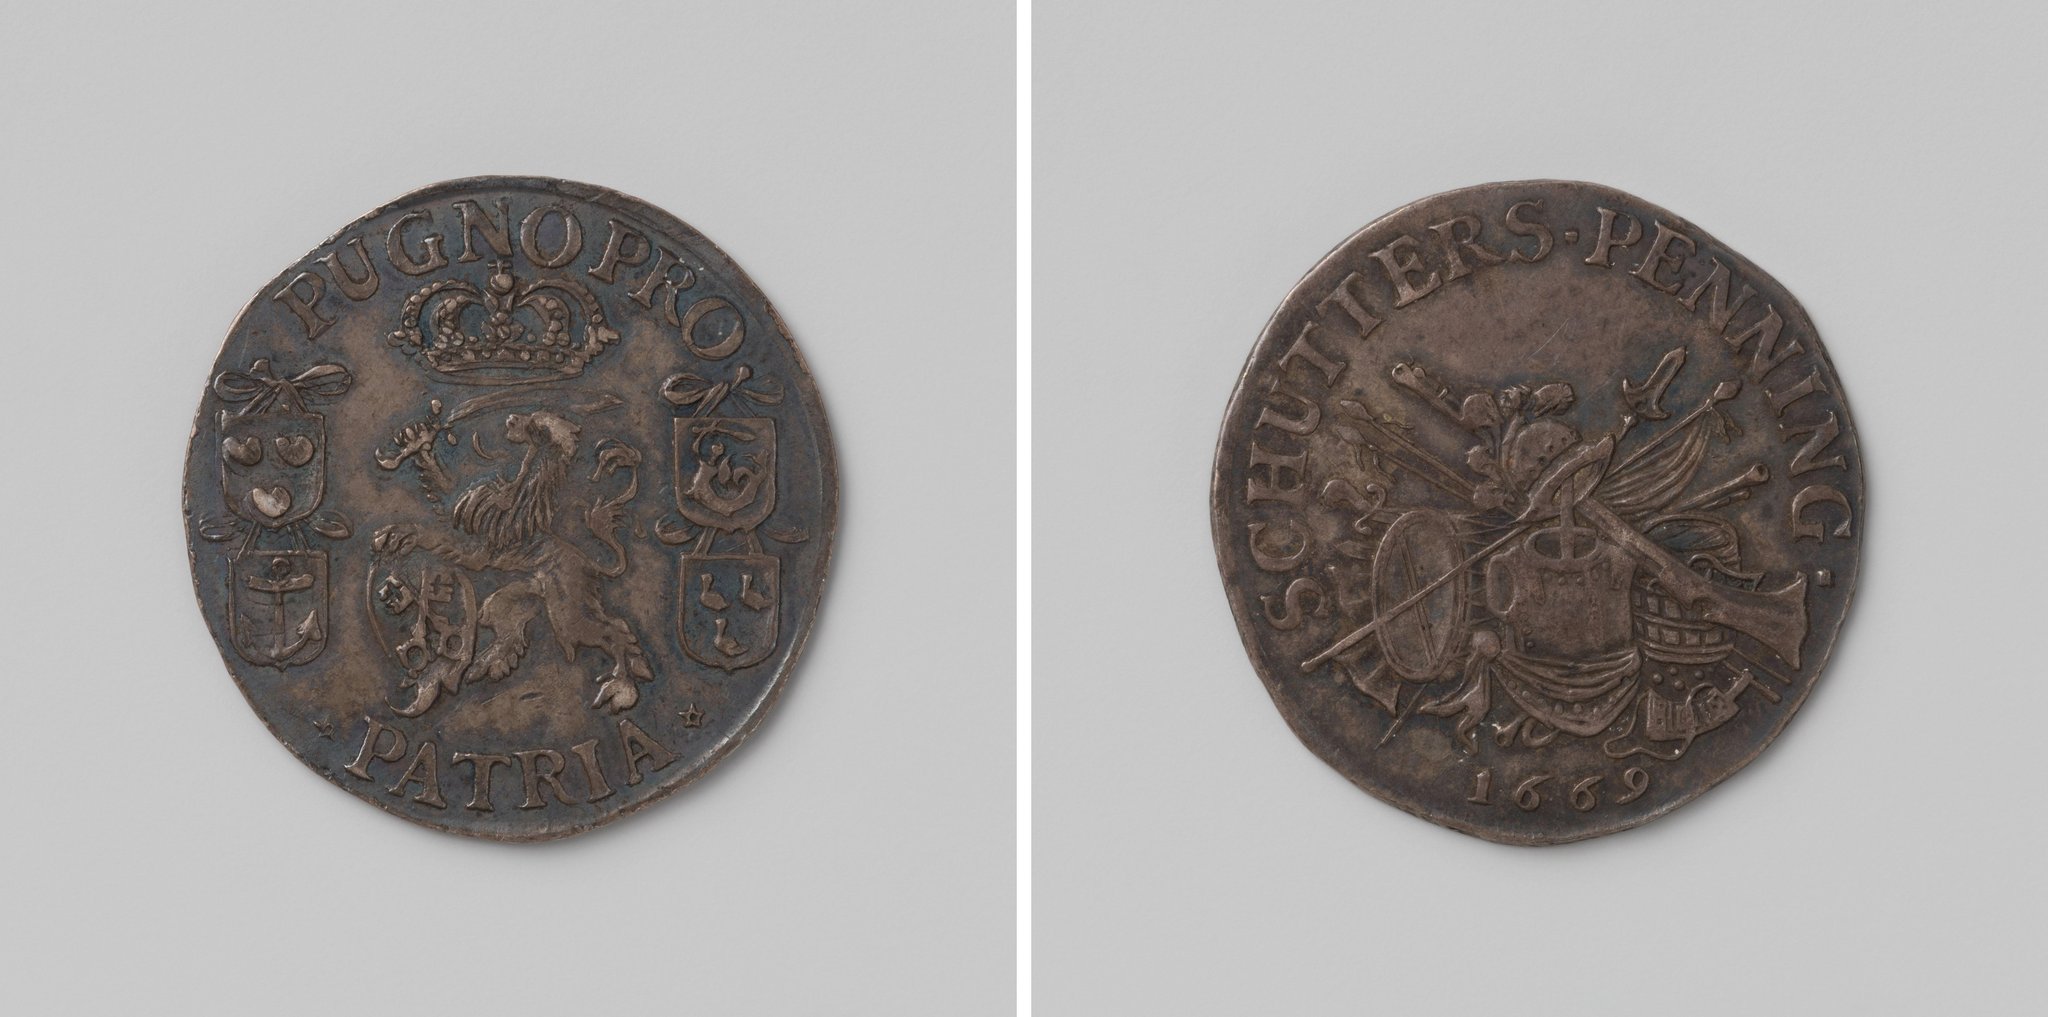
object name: marksman medal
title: Schutterij van Leiden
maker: arent jansz. schmeltzing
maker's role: medailleur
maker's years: 1639-1682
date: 1669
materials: silver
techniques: striking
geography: leiden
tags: leiden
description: Zilveren penning. Voorzijde: leeuw met zwaard in boven hoofd geheven rechterklauw en schild in linkerklauw onder kroon tussen vier wapenschilden binnen omschrift. Keerzijde: wapentrophee bestaande uit harnas, trommel, vaandels en wapentuig boven jaartal binnen omschrift